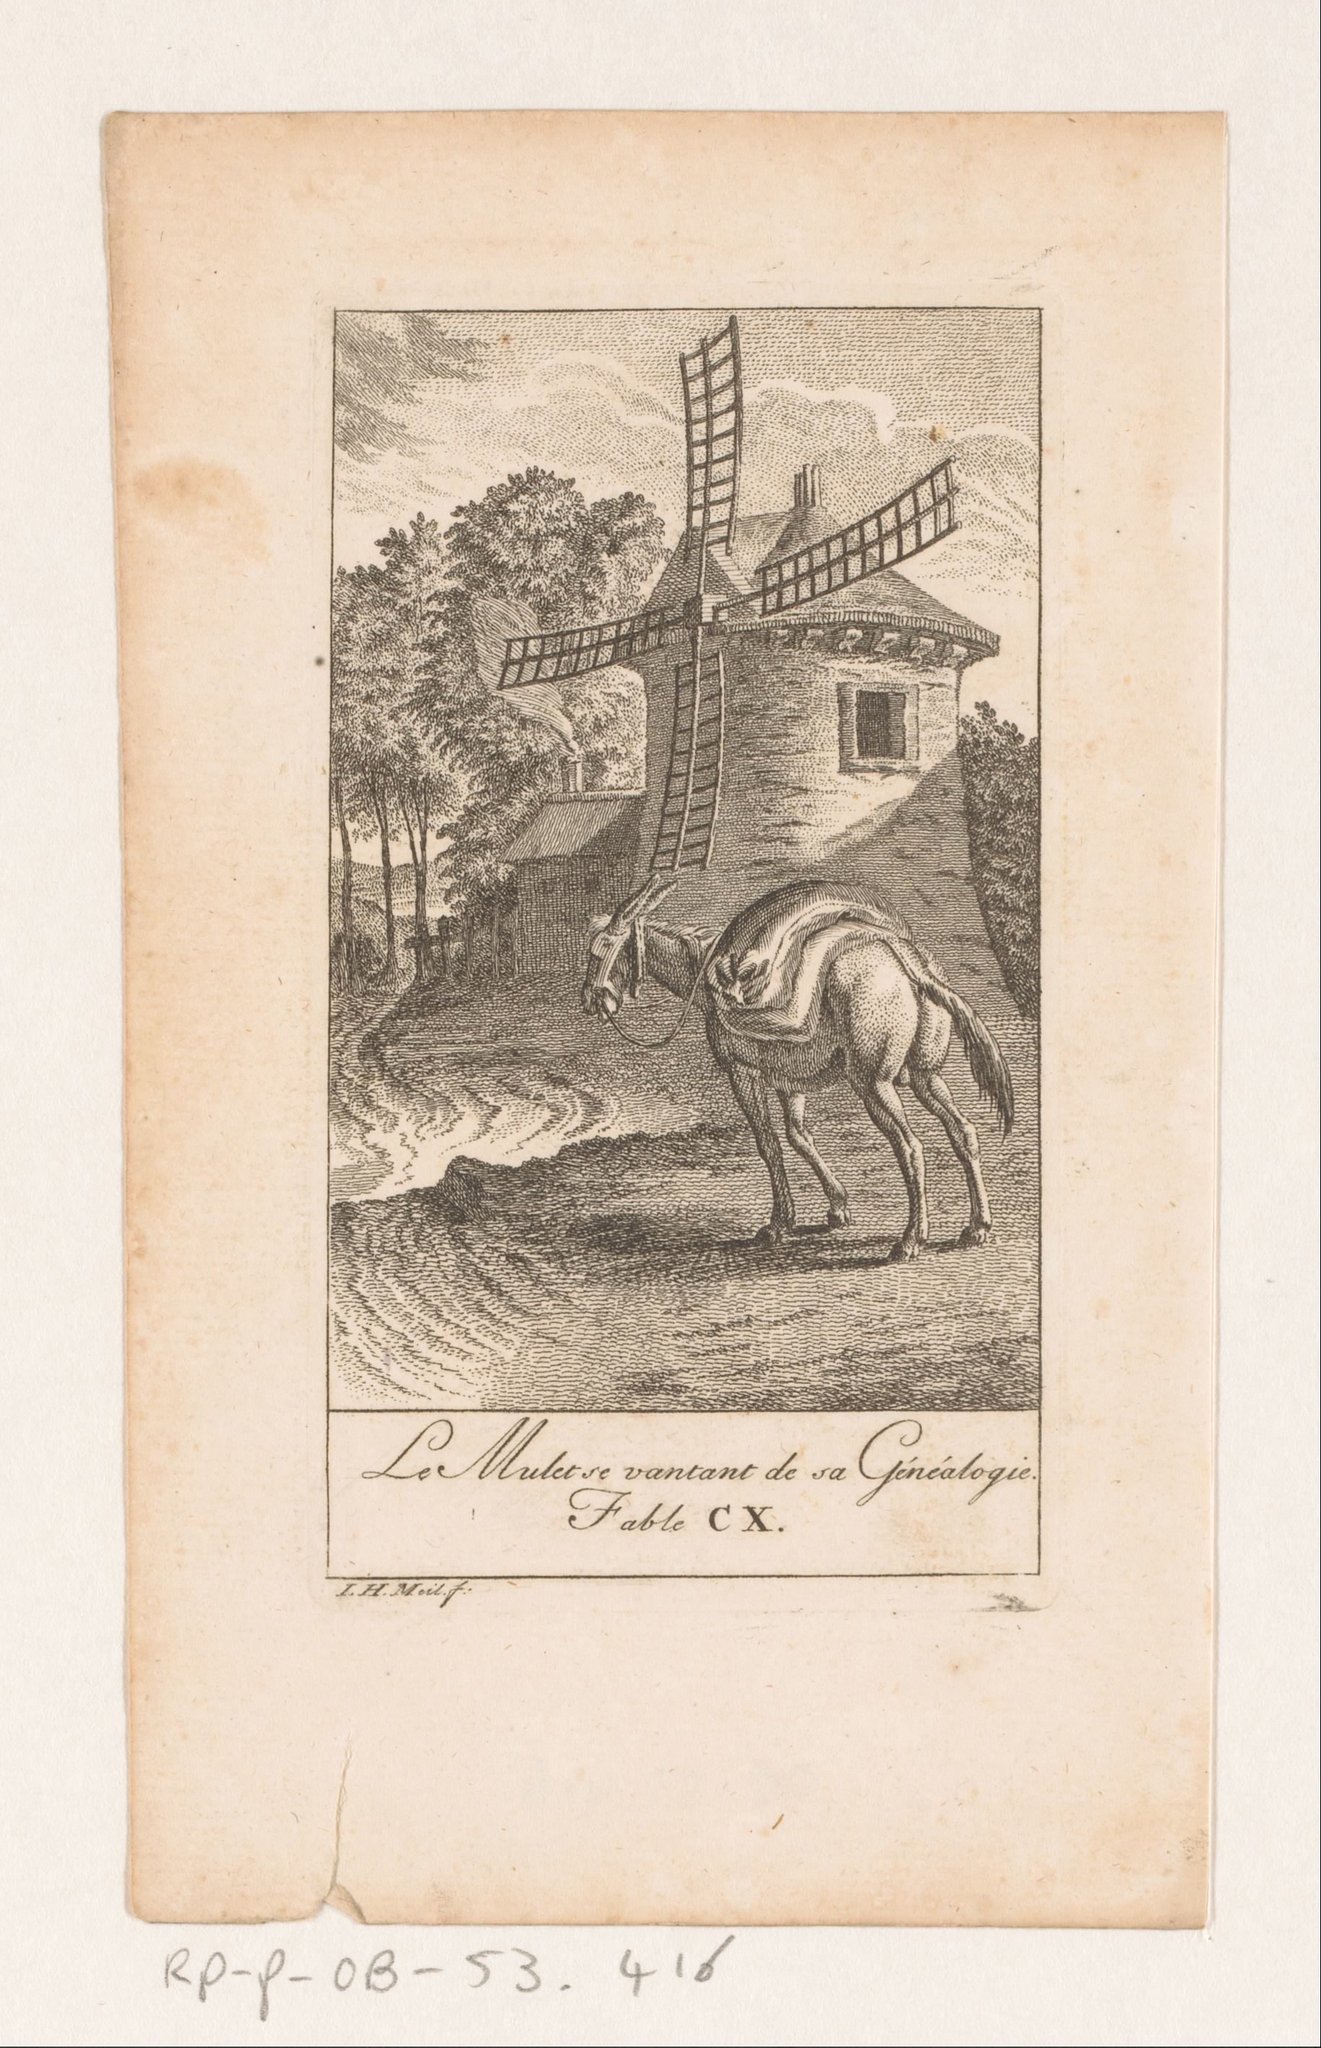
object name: book illustration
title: Le mulet se vantant de sa généalogie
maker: johann heinrich meil (der ältere)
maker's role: print maker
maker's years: 1730-1820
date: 1758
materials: paper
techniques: etching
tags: fables of lafontaine : use 85(...), windmill in landscape, mule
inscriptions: collector's mark: Lugt 2228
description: Illustratie uit: Fontaine, J. de la. Fables choisies, mises en vers. Dl. 2. Dresden & Leipzig: George Conrad Walther, 1758.